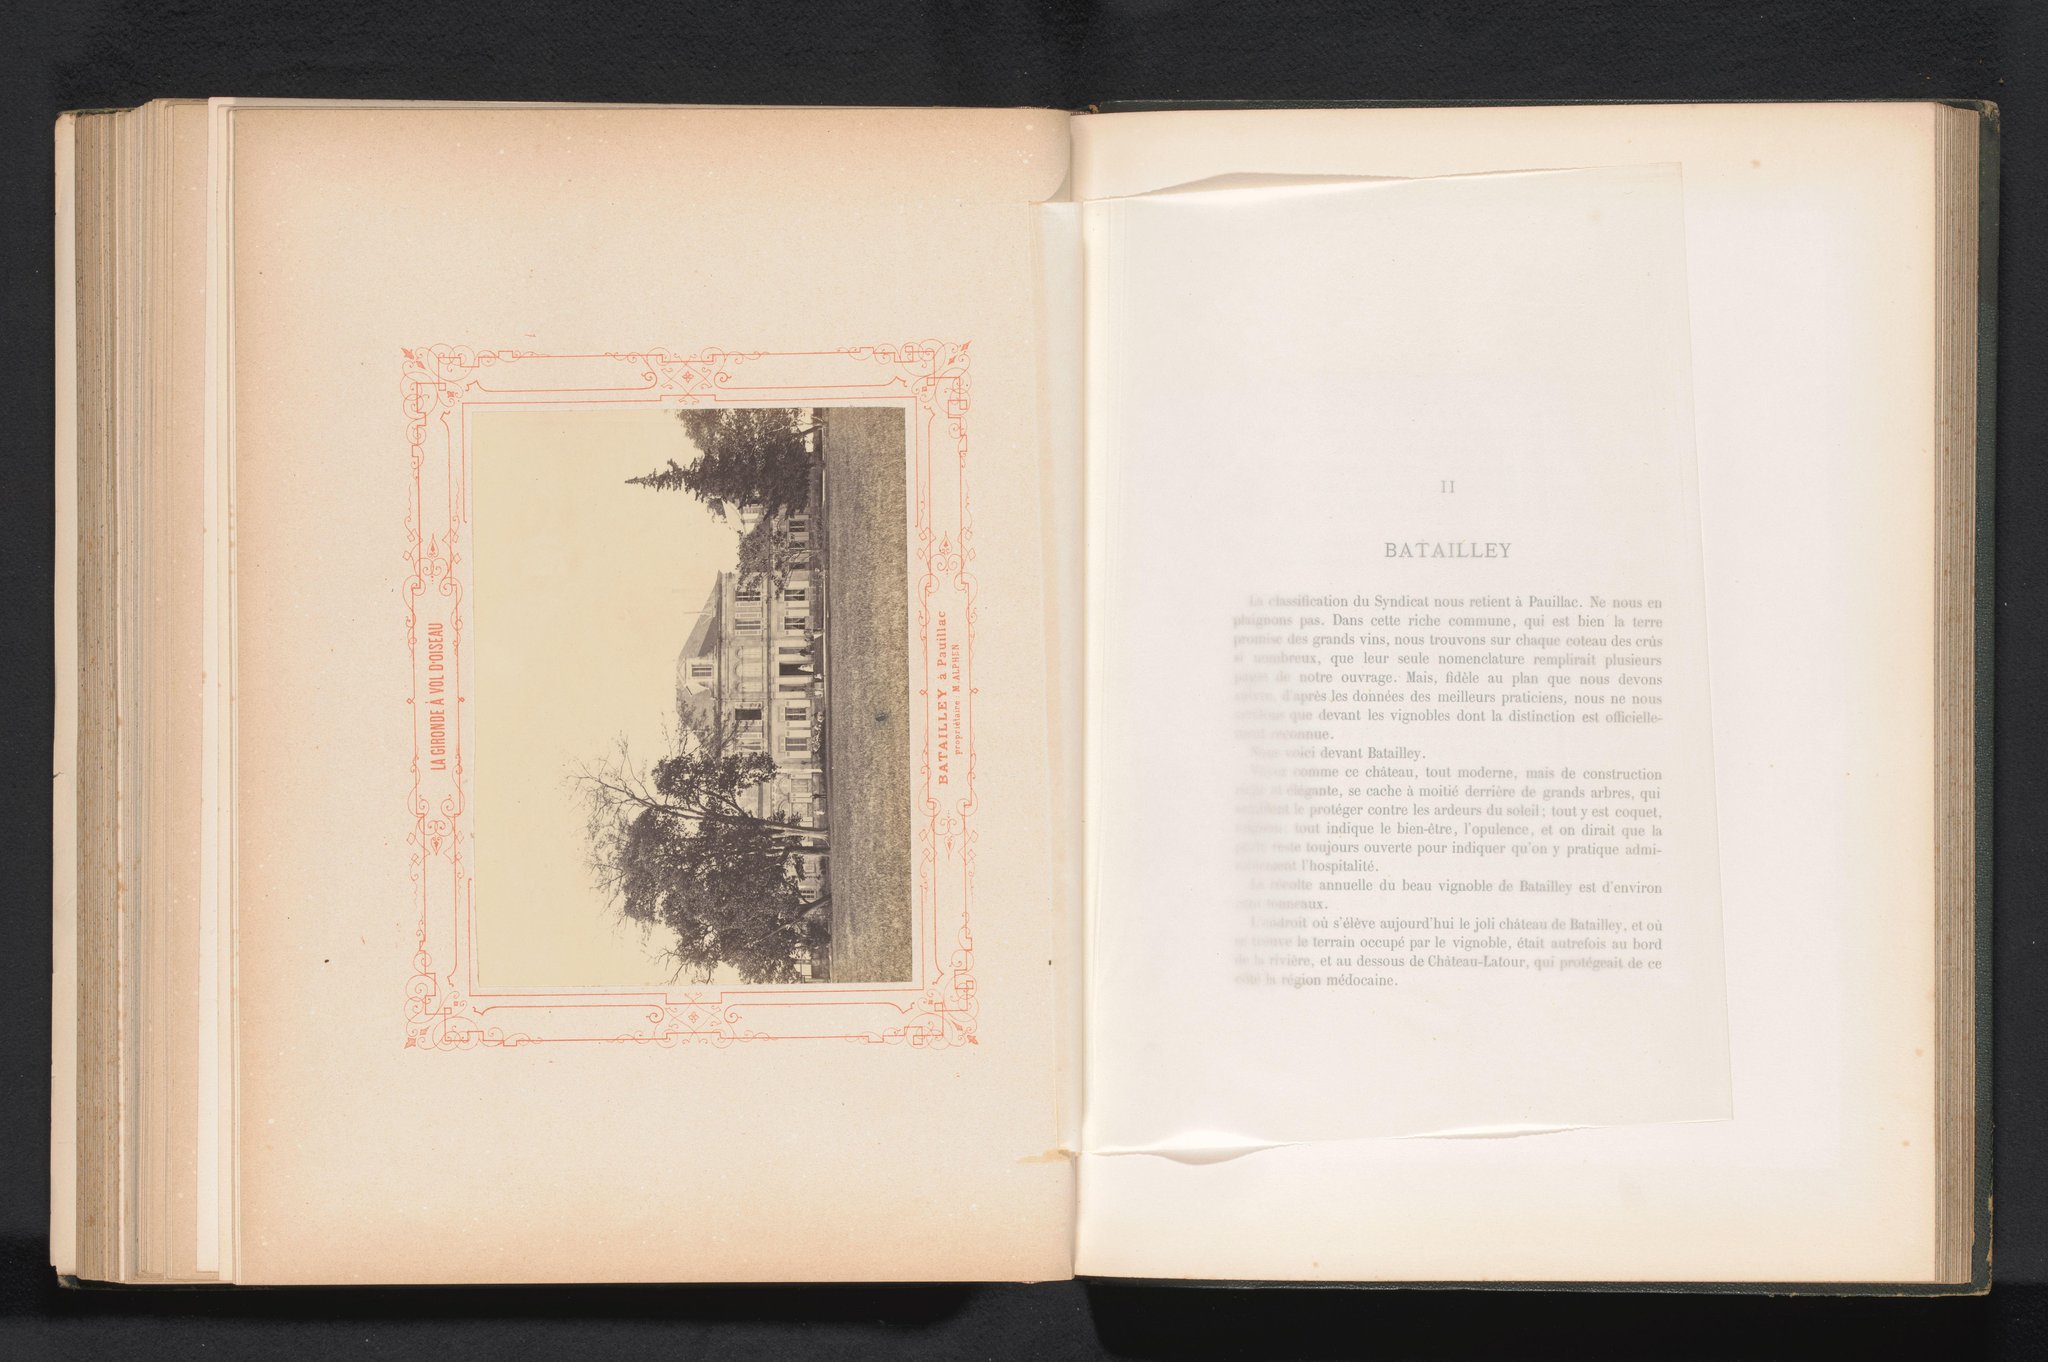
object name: photograph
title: Gezicht op Château Batailley in Pauillac, Frankrijk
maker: alfred danflou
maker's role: fotograaf, schrijver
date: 1862-1867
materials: photographic support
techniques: albumen print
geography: pauillac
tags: castle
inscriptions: inscription: ‘propriétaire: M. ALPHEN.’